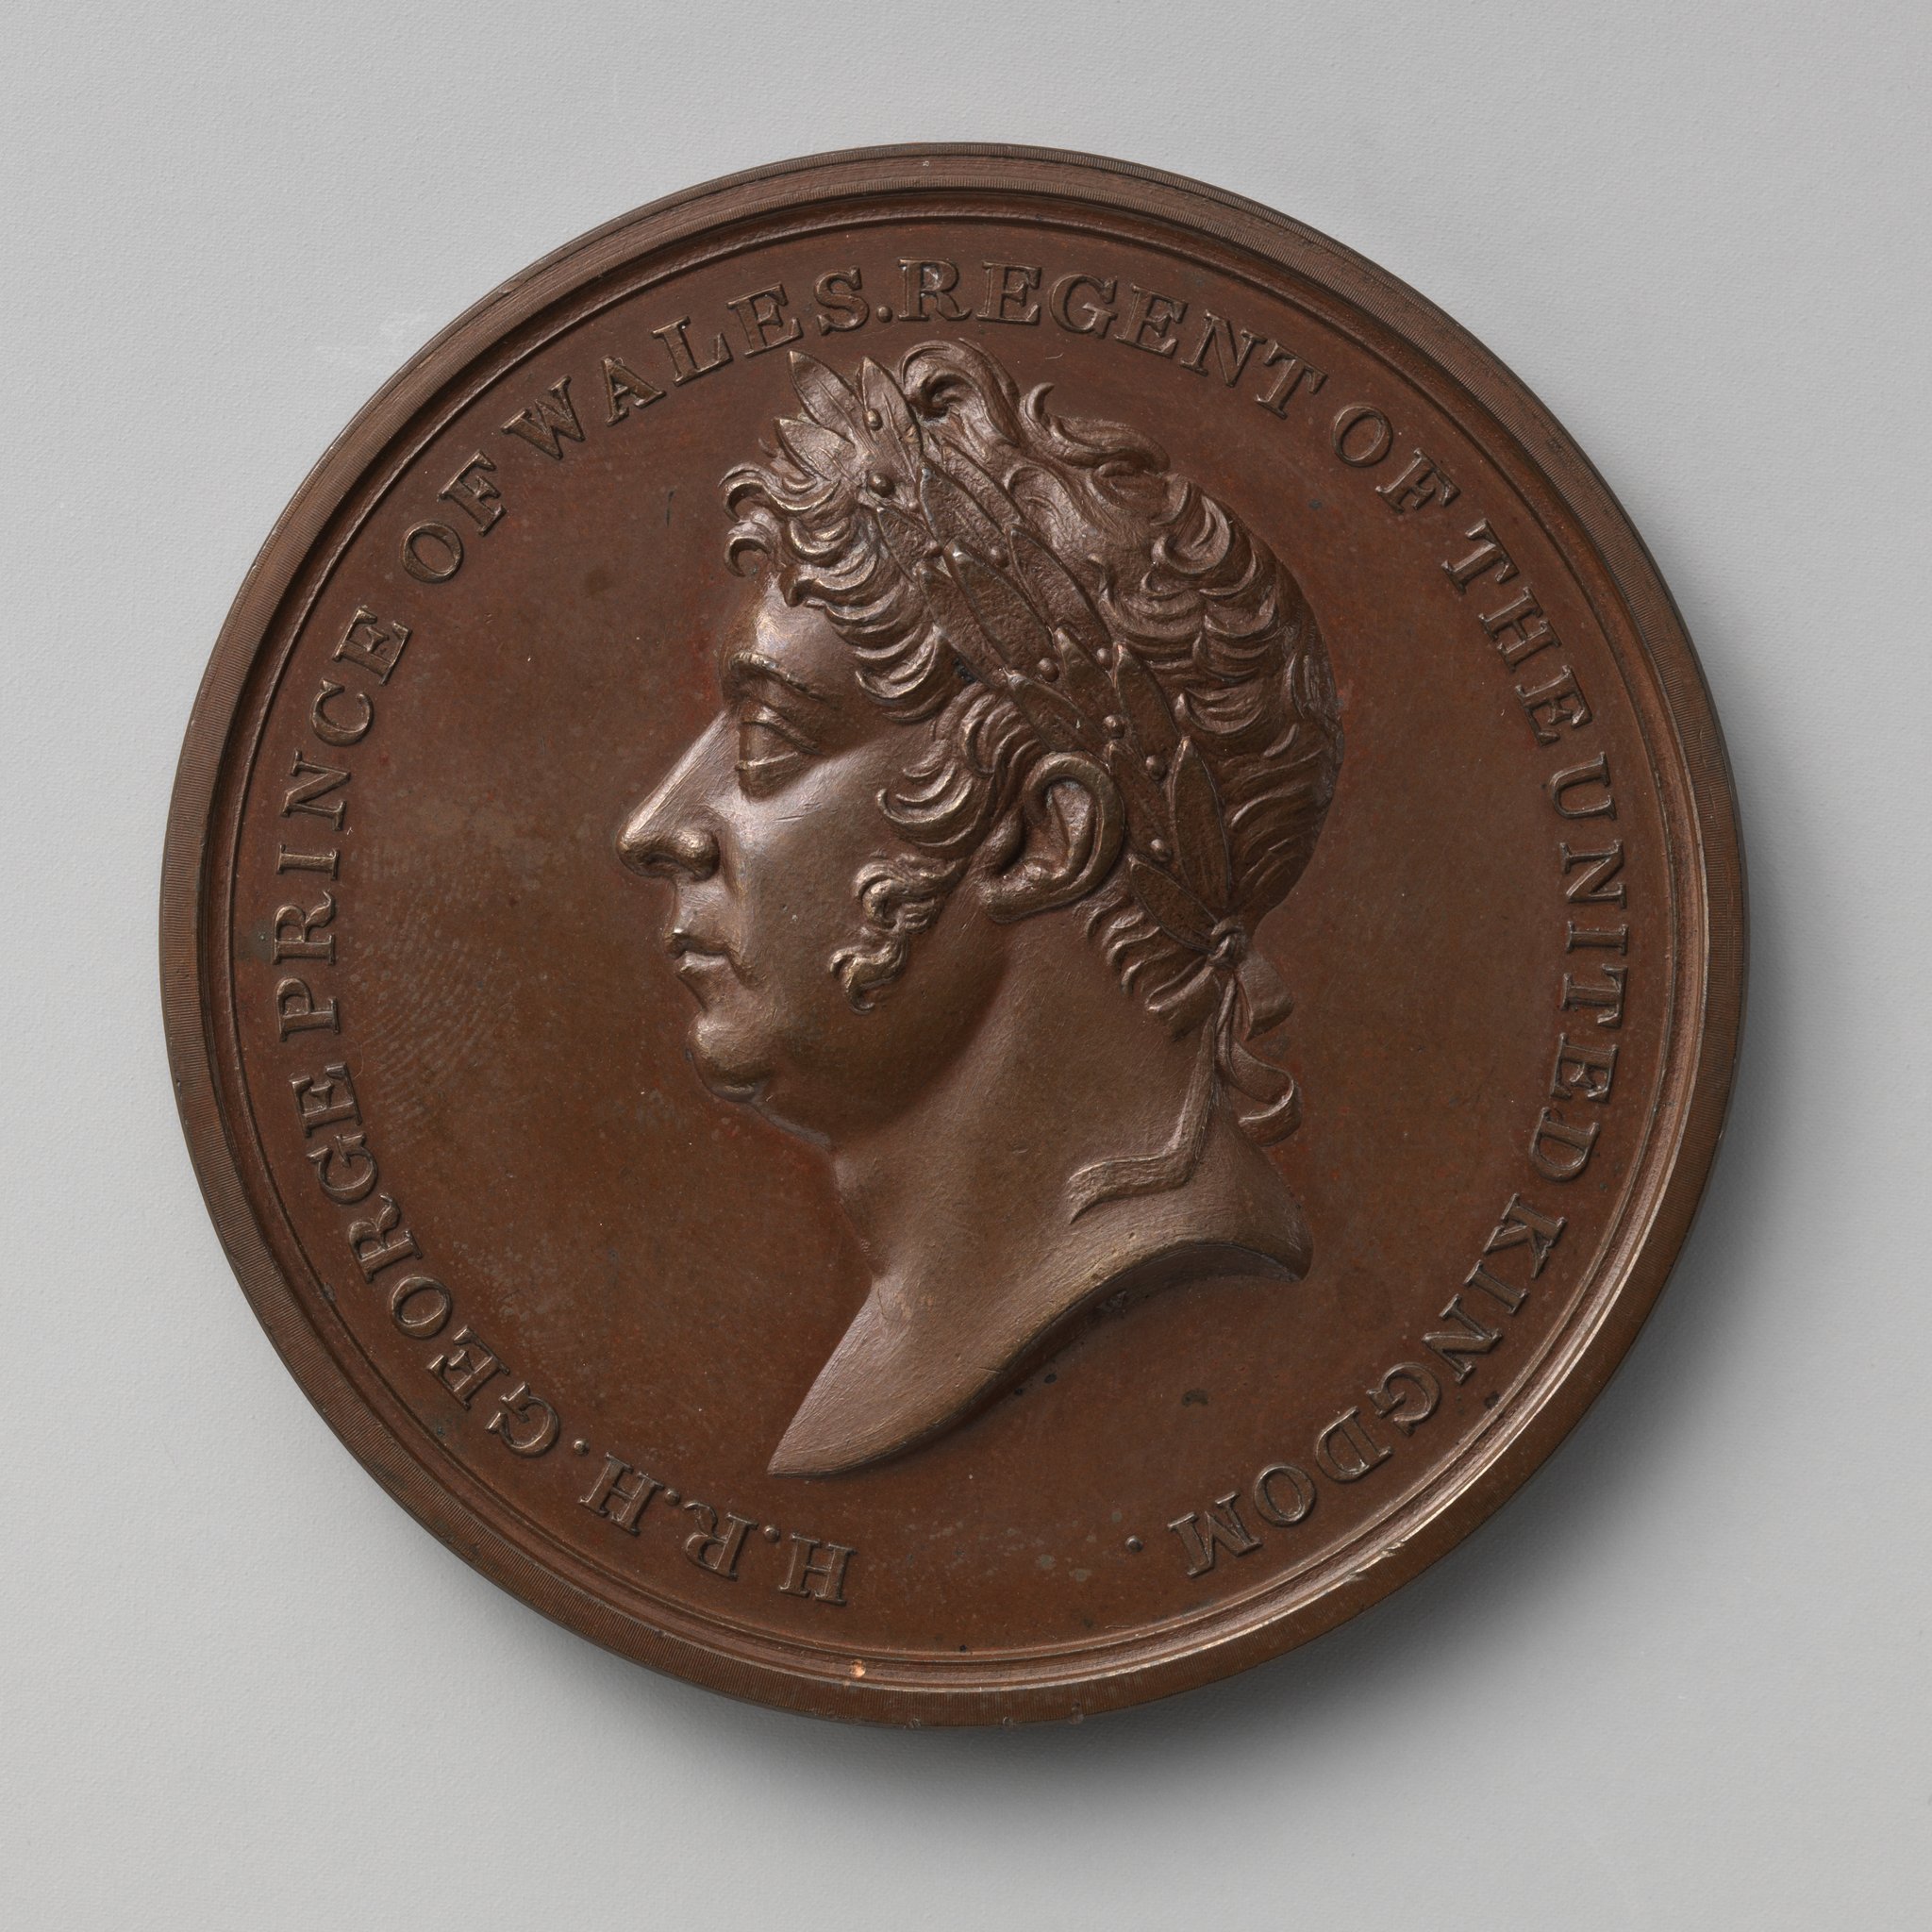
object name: medal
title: To the Prince Regent, on Conclusion of Peace, Subsequent to Waterloo, 1815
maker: thomas wyon the younger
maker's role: artist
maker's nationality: british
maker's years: 1791-1817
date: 1815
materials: bronze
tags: men,profiles